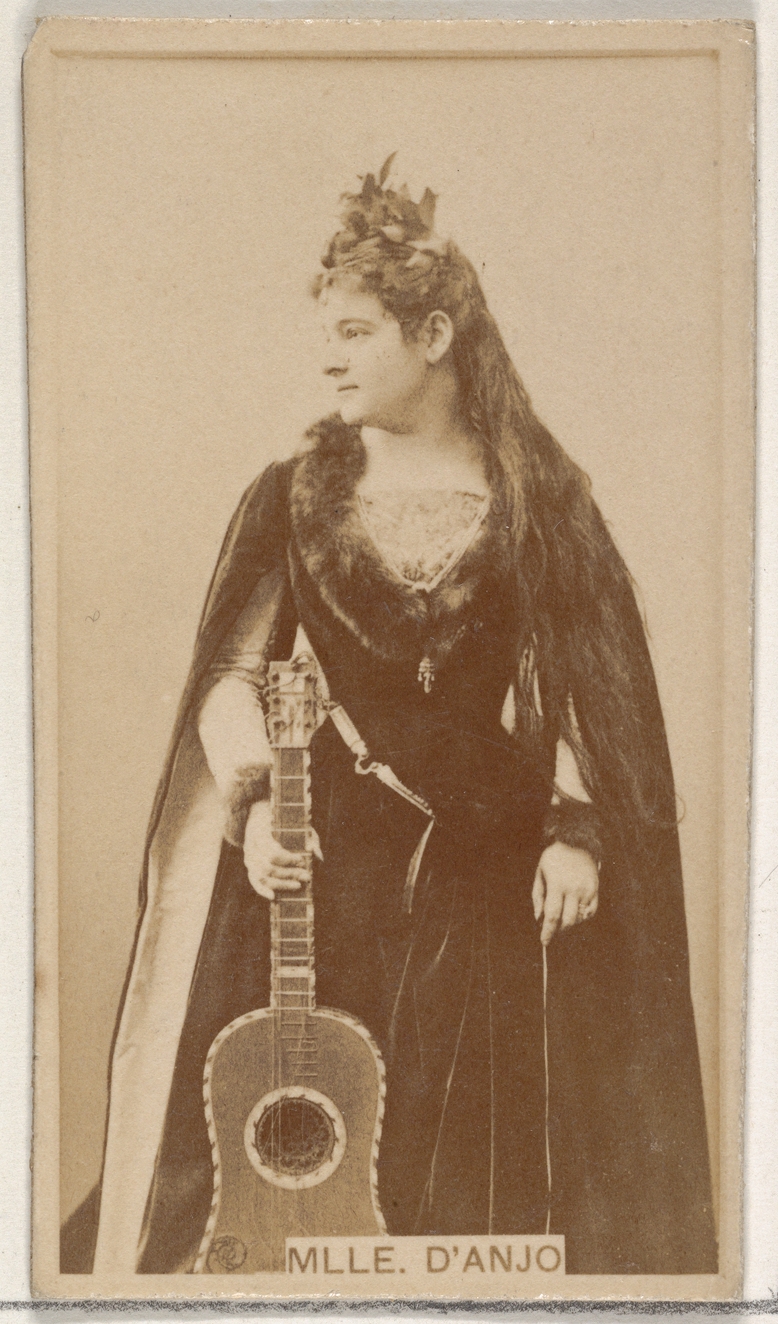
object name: photograph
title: Mlle. D' Anjo, from the Actors and Actresses series (N45, Type 8) for Virginia Brights Cigarettes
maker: allen & ginter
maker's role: publisher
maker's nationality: american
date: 1888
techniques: albumen silver print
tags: portraits,women,guitars,actresses